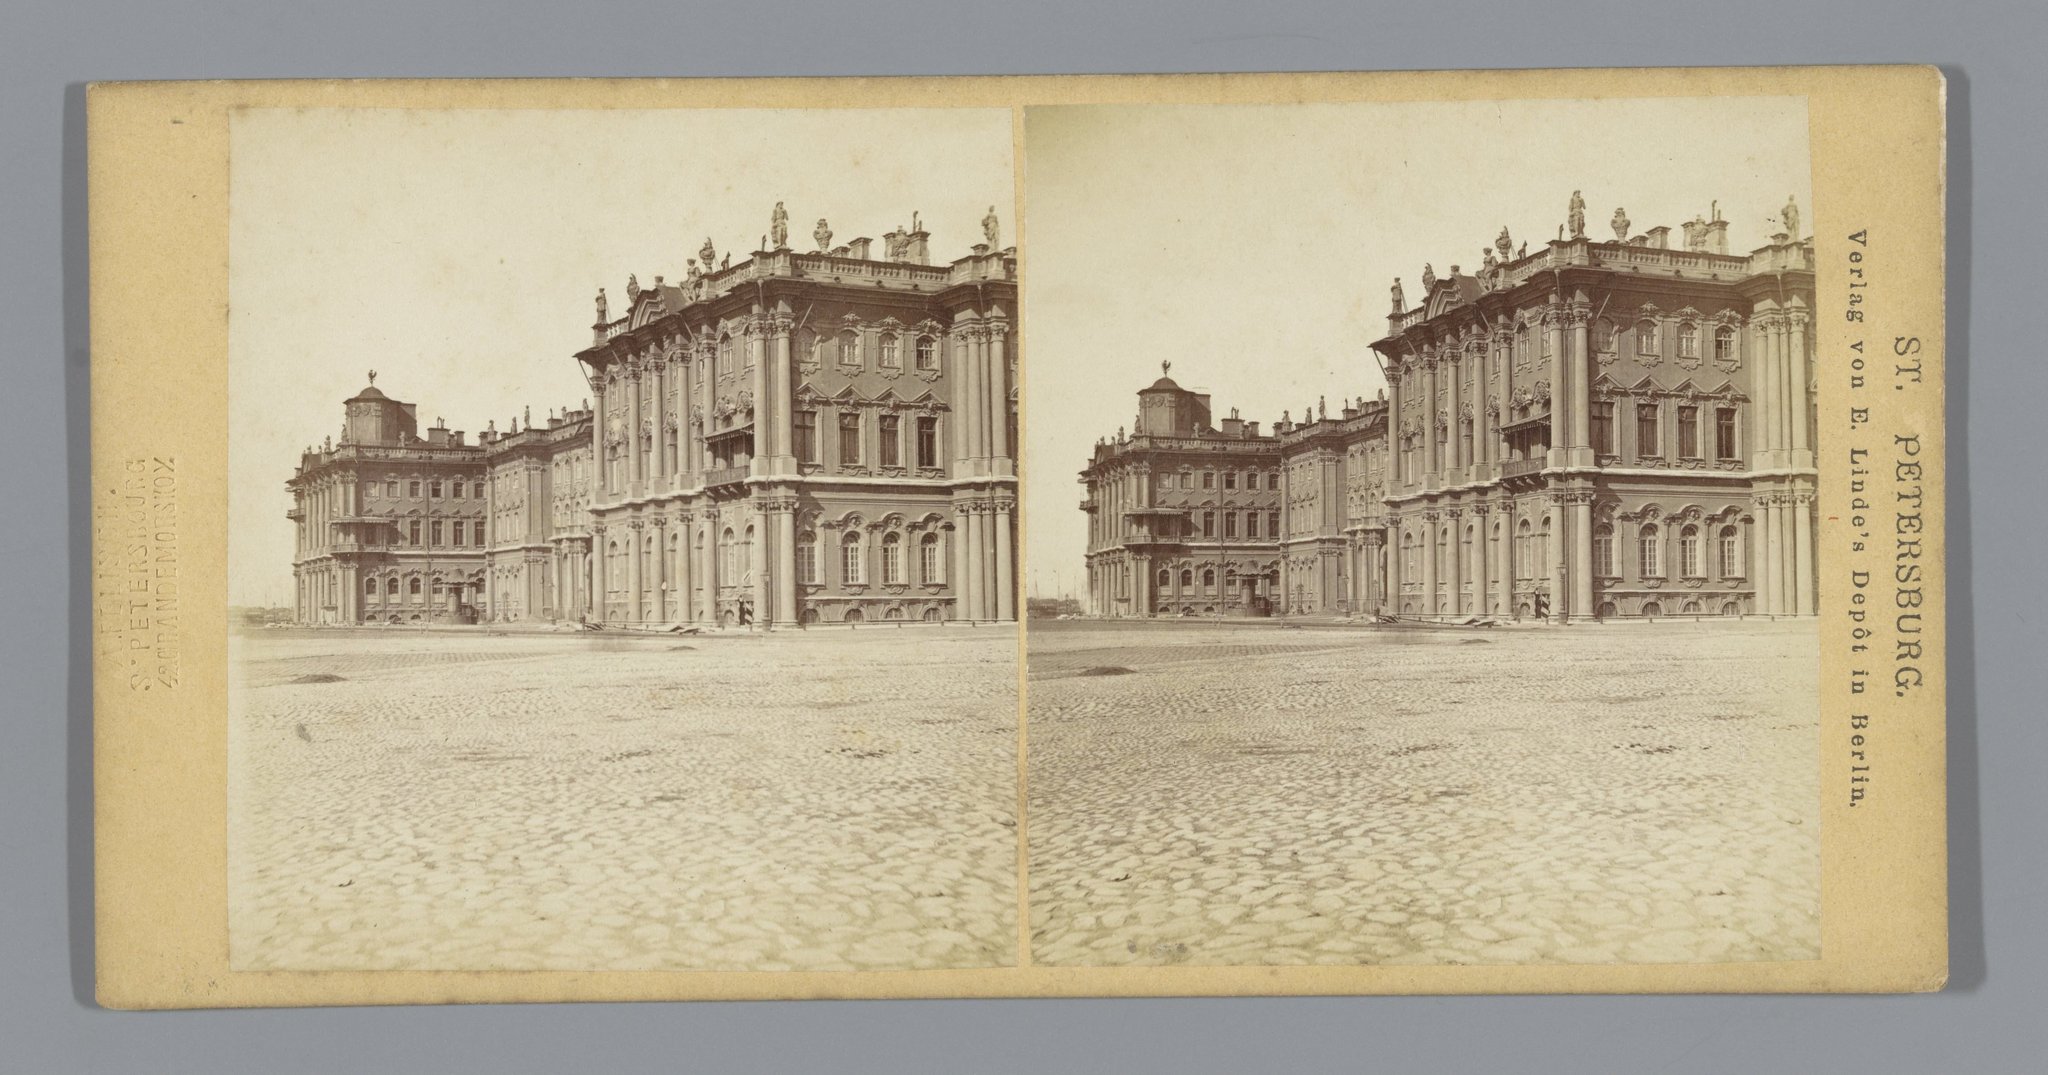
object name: stereograph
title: Gezicht op het Winterpaleis in Sint-Petersburg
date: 1850-1880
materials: cardboard, photographic support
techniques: albumen print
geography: berlin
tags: palace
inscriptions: name: ‘ST. PETERSBURG. Verlag von E. Linde's Depôt in Berlin’, inscription: ‘Winter Palais’, name: ‘A. FELISCH. S. PETERSBOURG 42. GRANDEMORSKOY.’